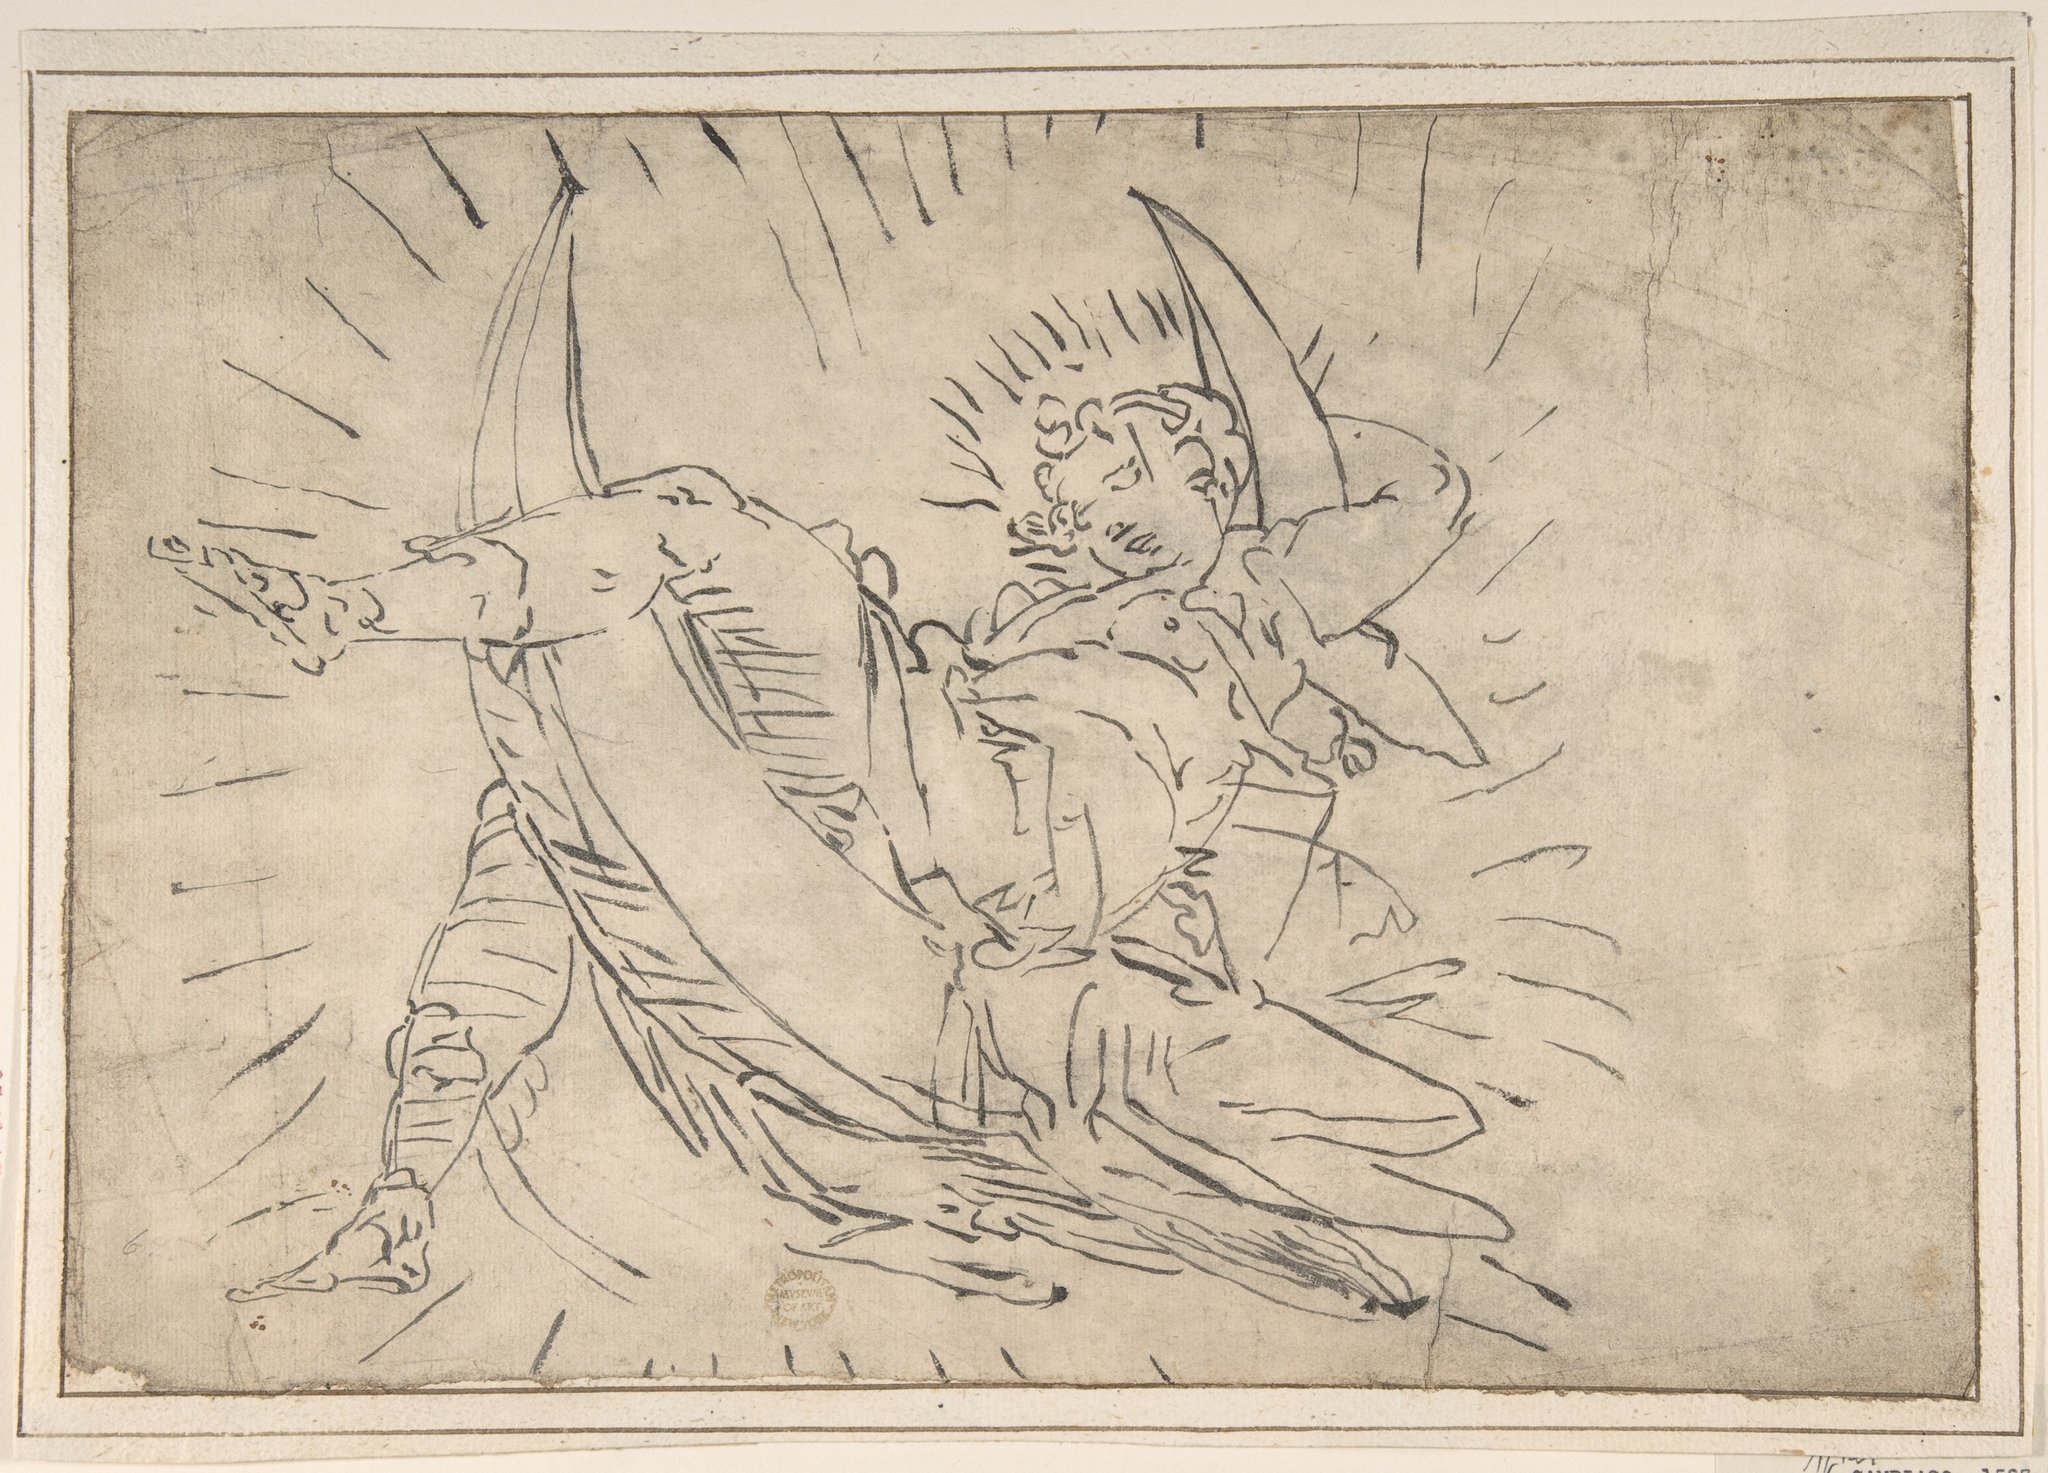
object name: drawing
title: Diana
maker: luca cambiaso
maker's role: artist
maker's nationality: italian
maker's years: 1527-1585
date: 1527-1585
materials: ink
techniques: brush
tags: diana